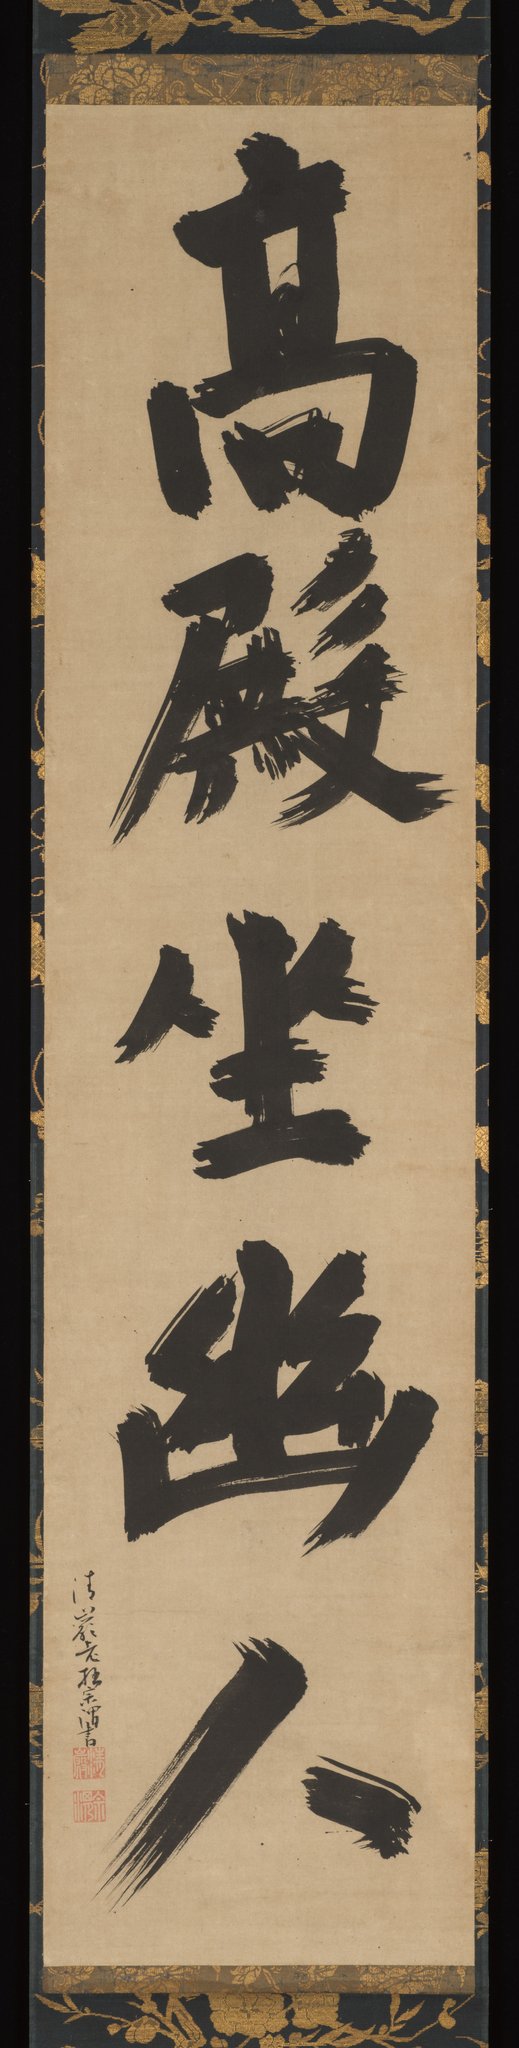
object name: hanging scroll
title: Line from a Poem by Li Bai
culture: japanese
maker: seigan sōi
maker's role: artist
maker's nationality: japanese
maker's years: 1588-1661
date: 1601-1633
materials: ink, paper